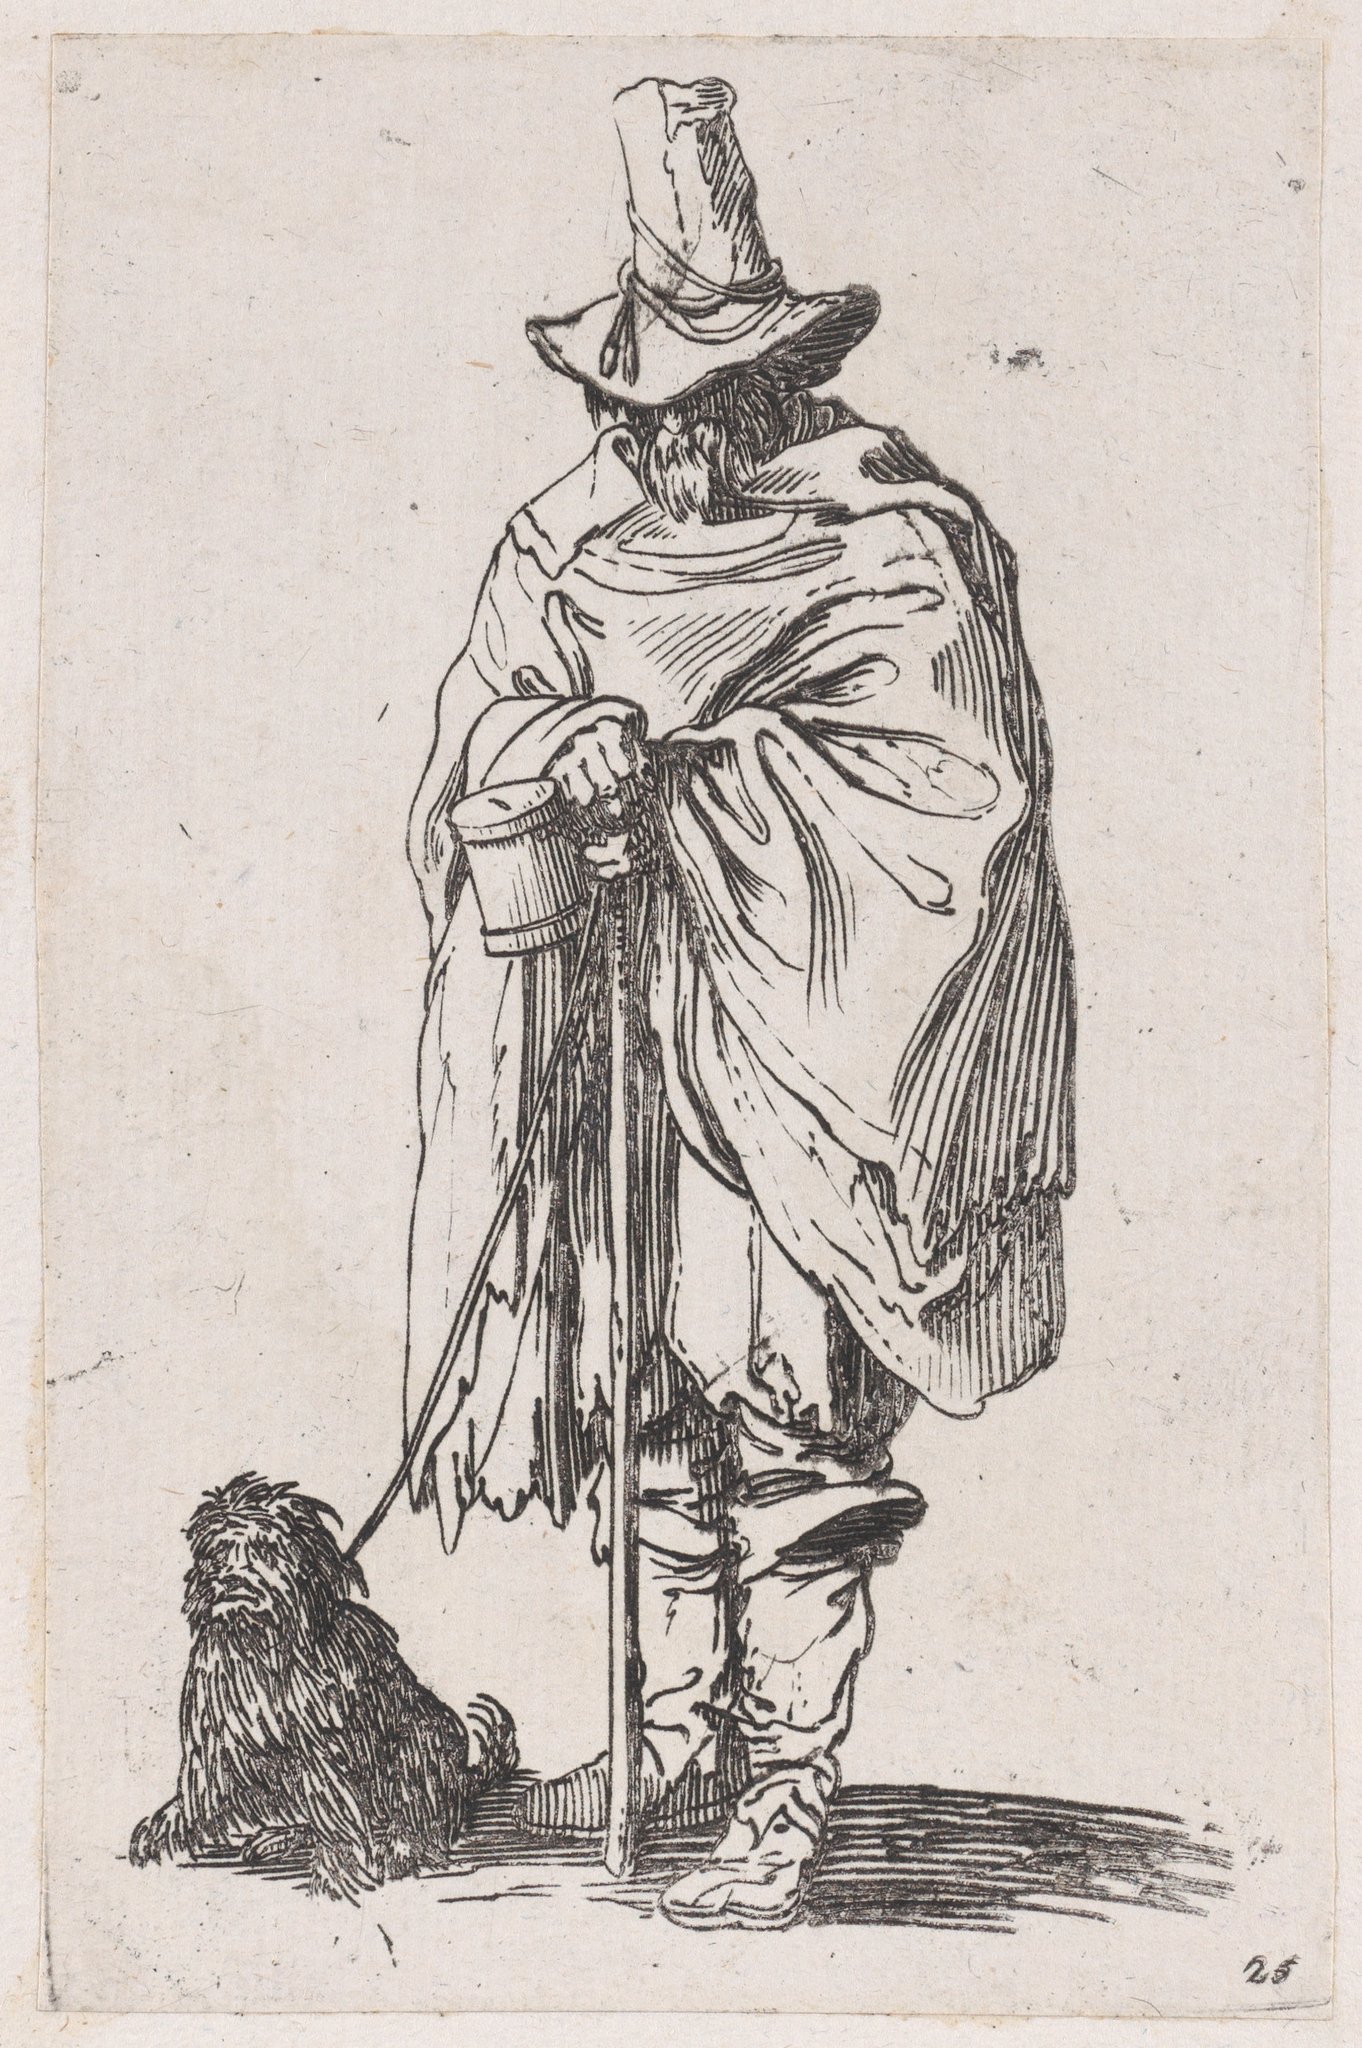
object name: print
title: Reverse Copy of Le Gentilhomme au Manteau Bordé de Fourrures Tentant ses Mains Derrière le Dos (The Gentleman with a Fur Lined Coat Holding his Hands Behind his Back), from La Noblesse (The Nobility)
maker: Anonymous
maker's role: artist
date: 1601-1700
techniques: etching